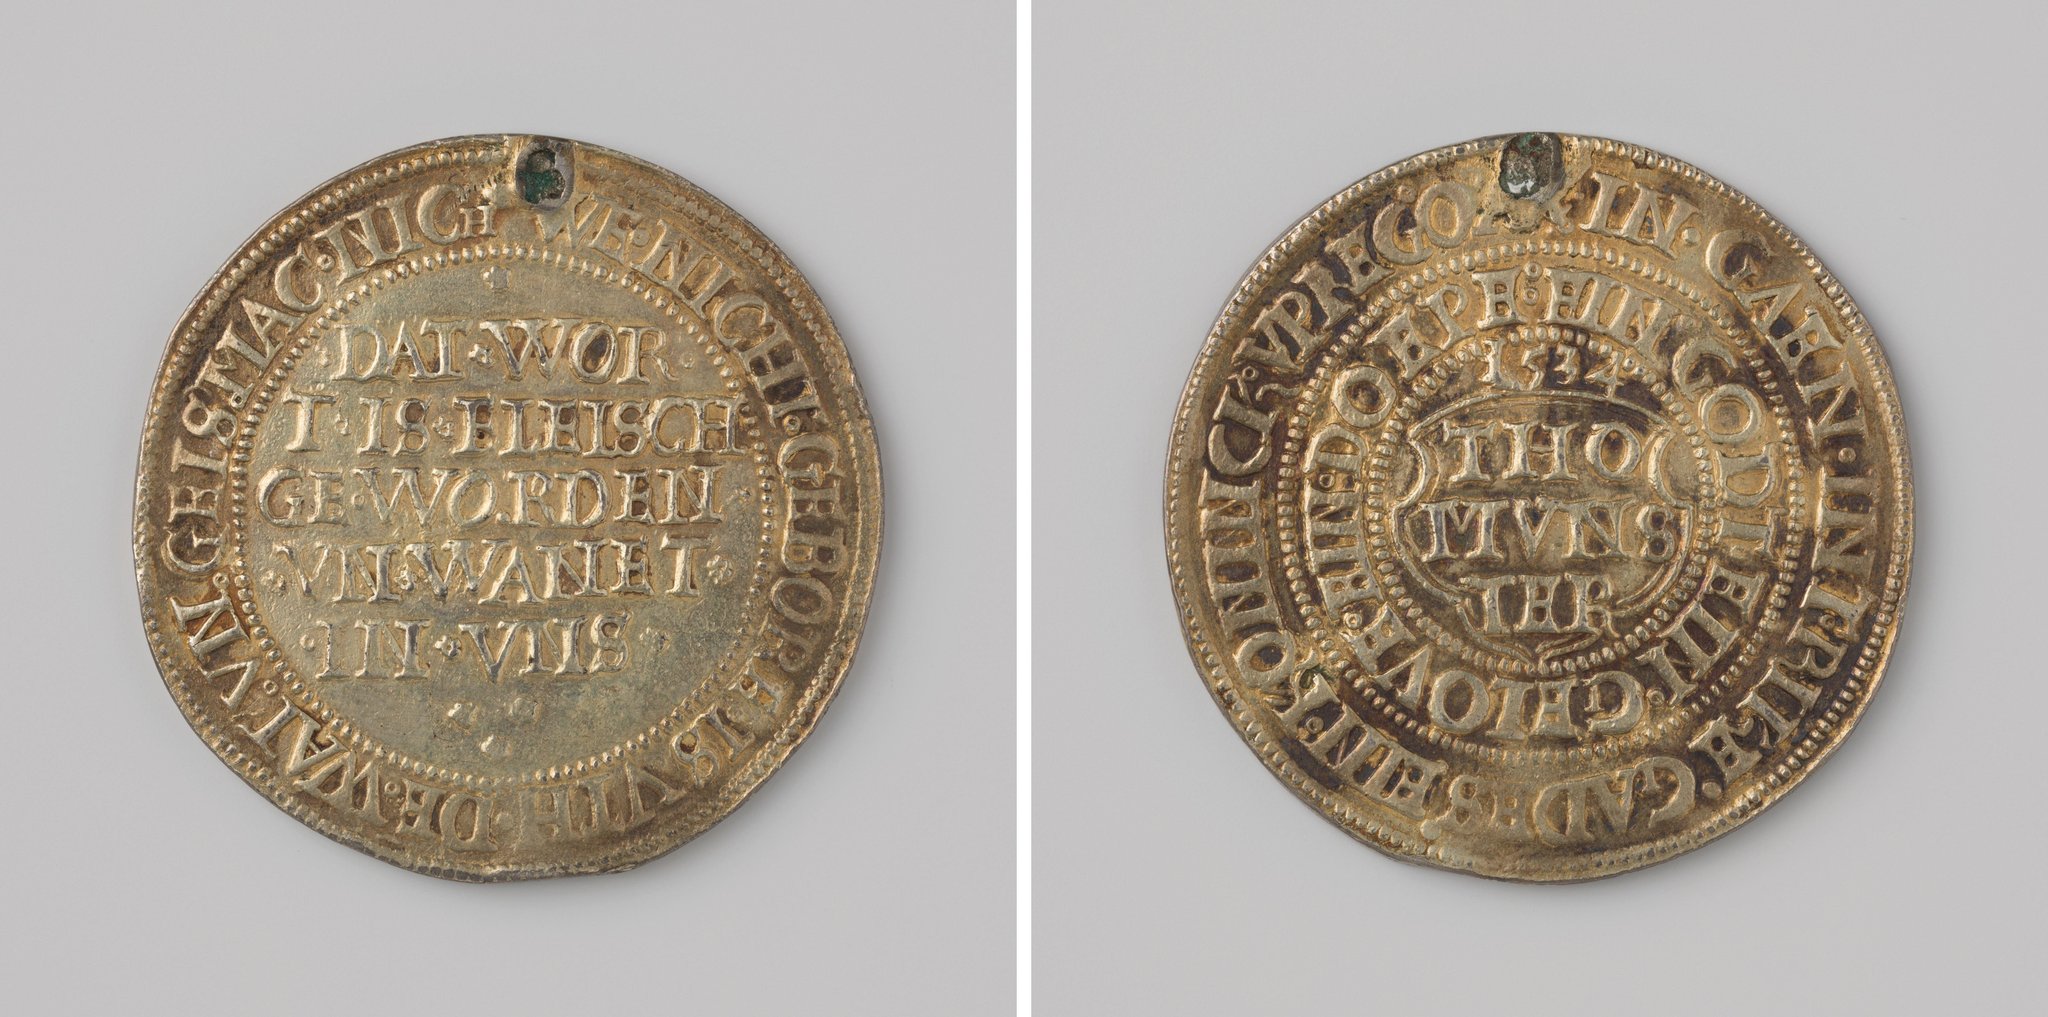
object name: history medal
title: Wederdopers te Munster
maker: Anonymous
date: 1534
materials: silver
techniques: gilding, striking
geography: munster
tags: münster, wederdopersoproer in münster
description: Zilveren penning met afgebroken draagoog. Voorzijde: opschrift binnen omschrift. Keerzijde: schild met opschrift onder jaartal binnen tweeregelig omschrift